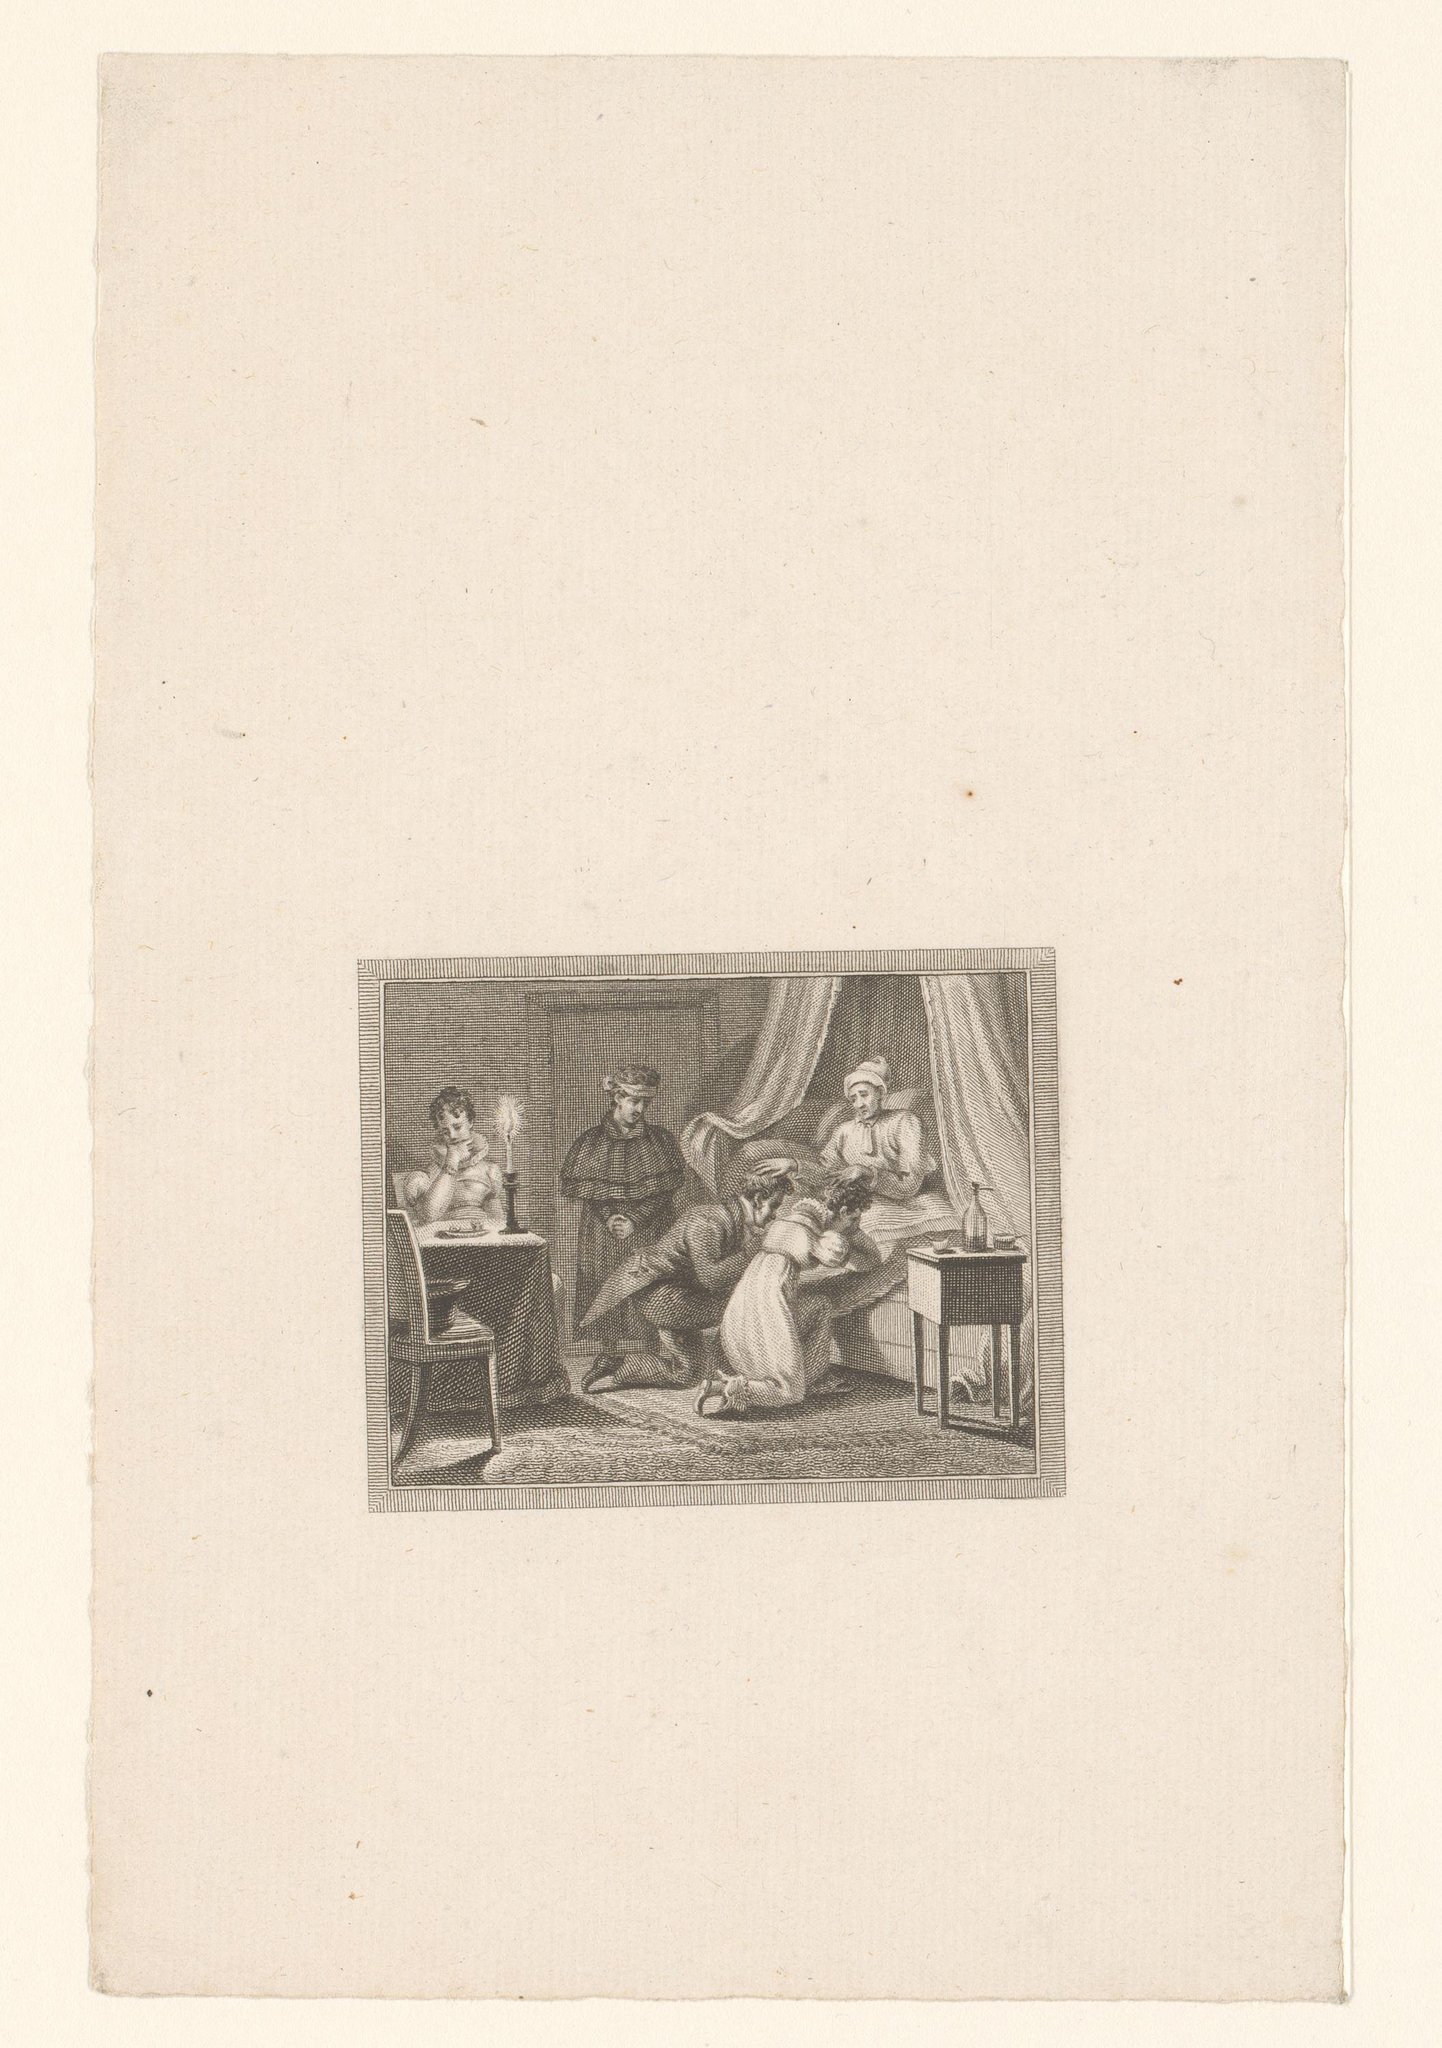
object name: print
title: Twee figuren knielend voor een man op zijn sterfbed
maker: Anonymous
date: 1800-1850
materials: paper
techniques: engraving, etching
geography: netherlands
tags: deathbed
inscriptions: collector's mark: Lugt 2228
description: Dit betreft waarschijnlijk een prent uit een onbekend boek.